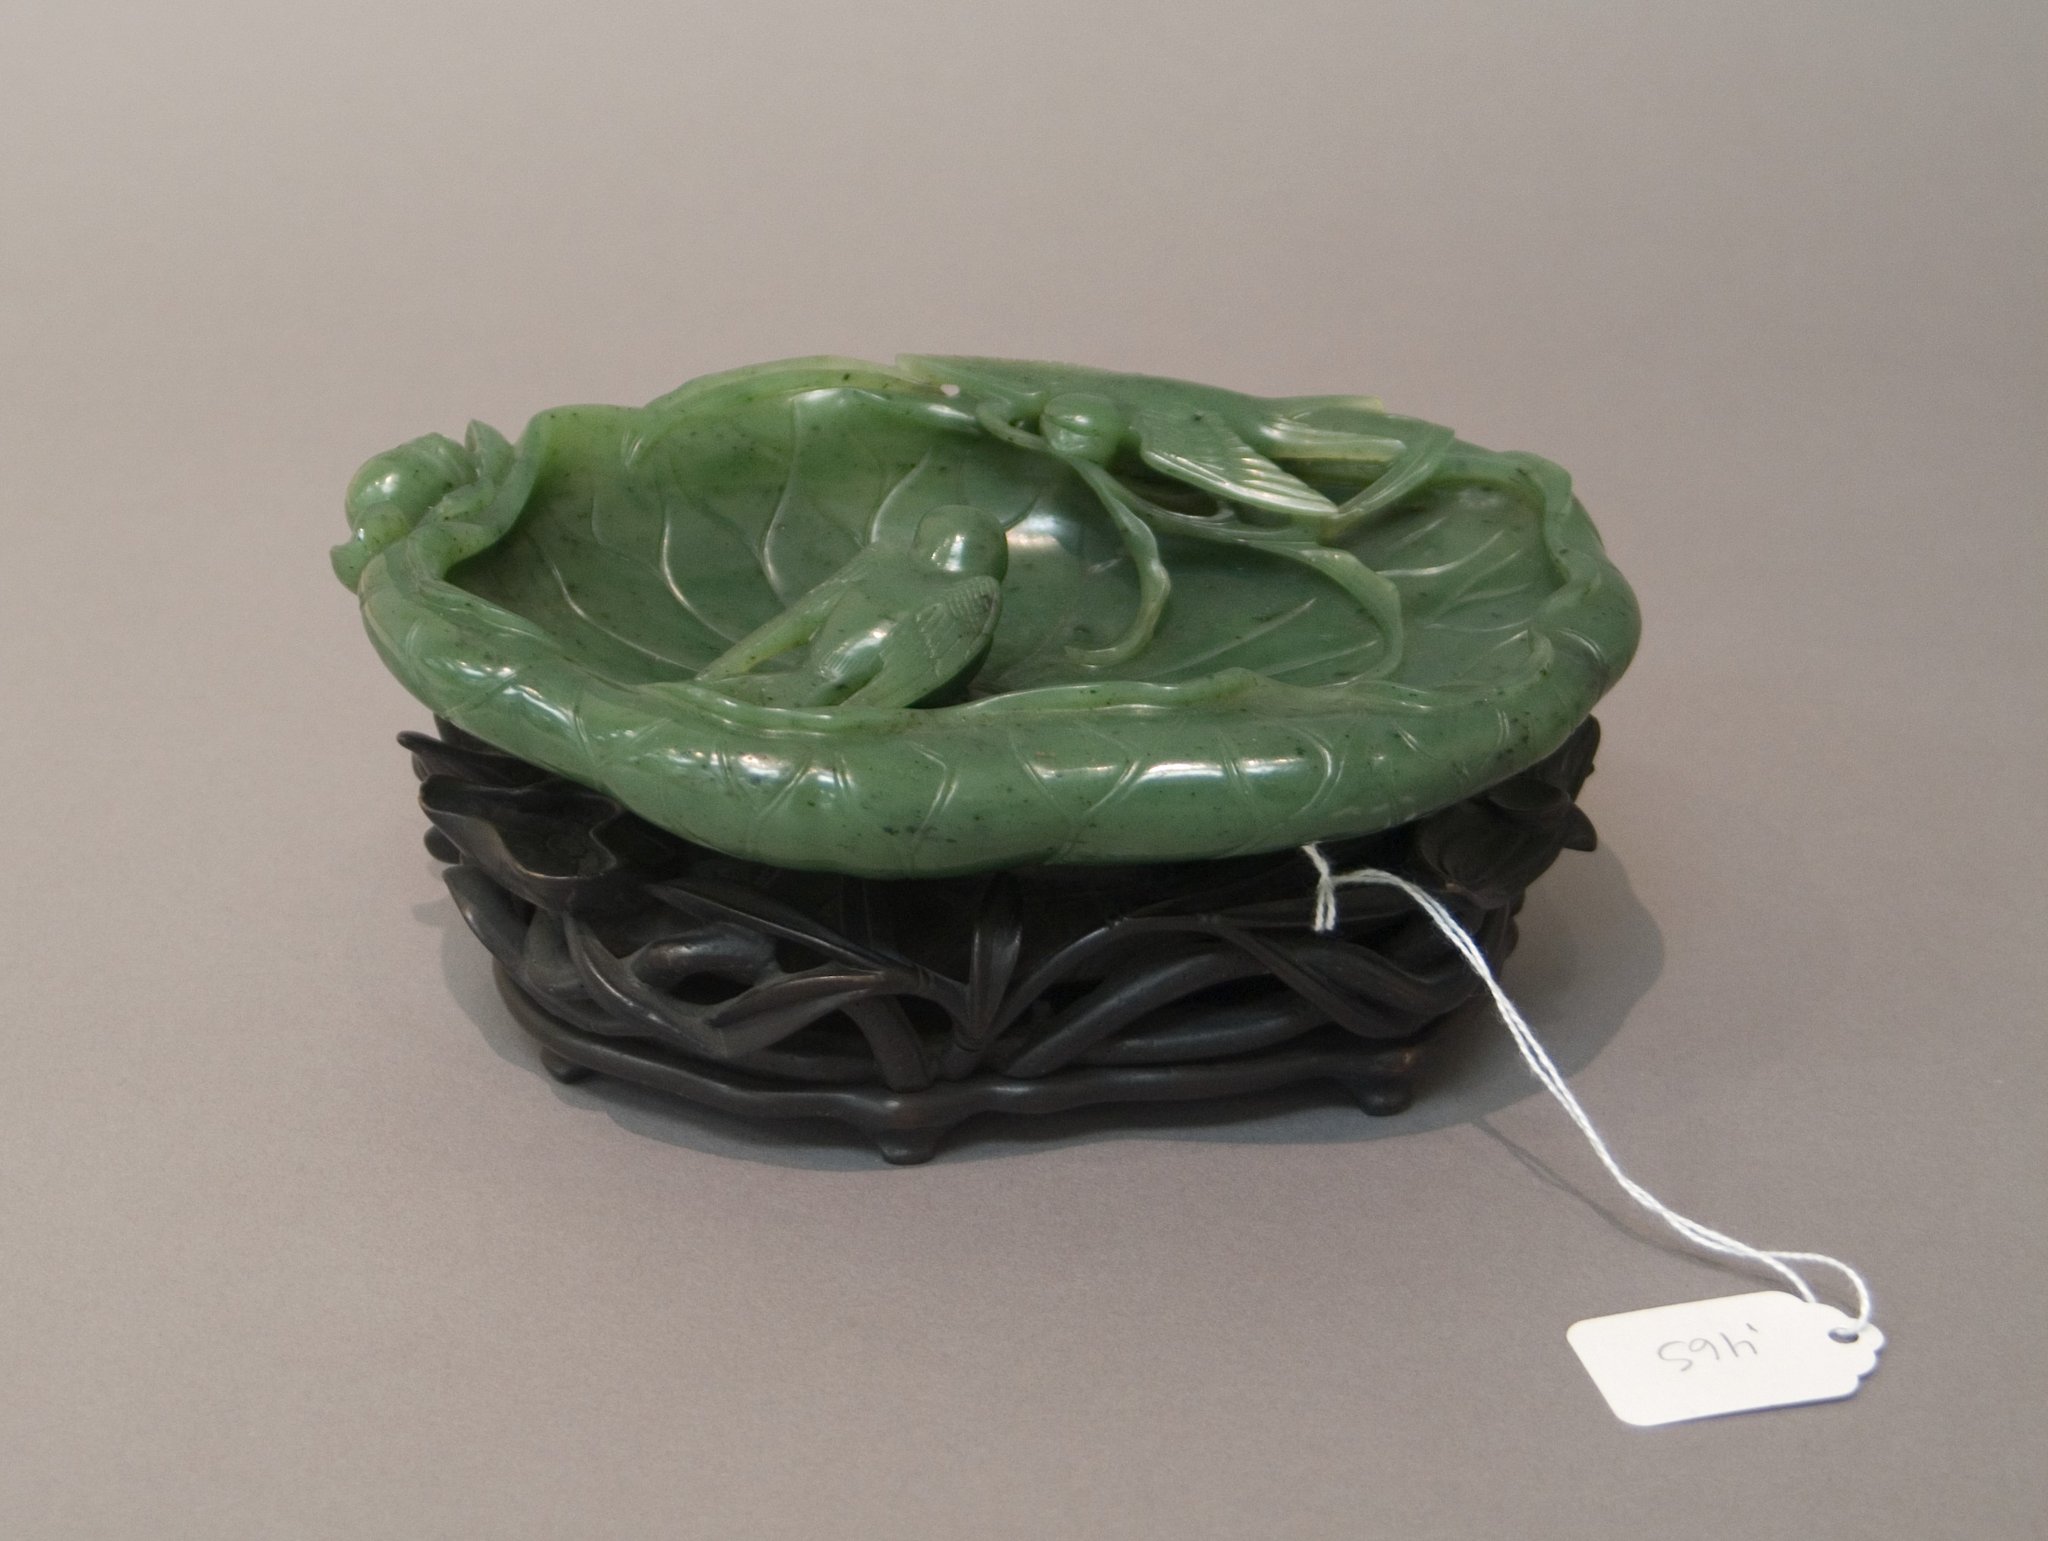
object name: dish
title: Lotus-Leaf Dish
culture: chinese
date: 1662-1722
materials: jade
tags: birds